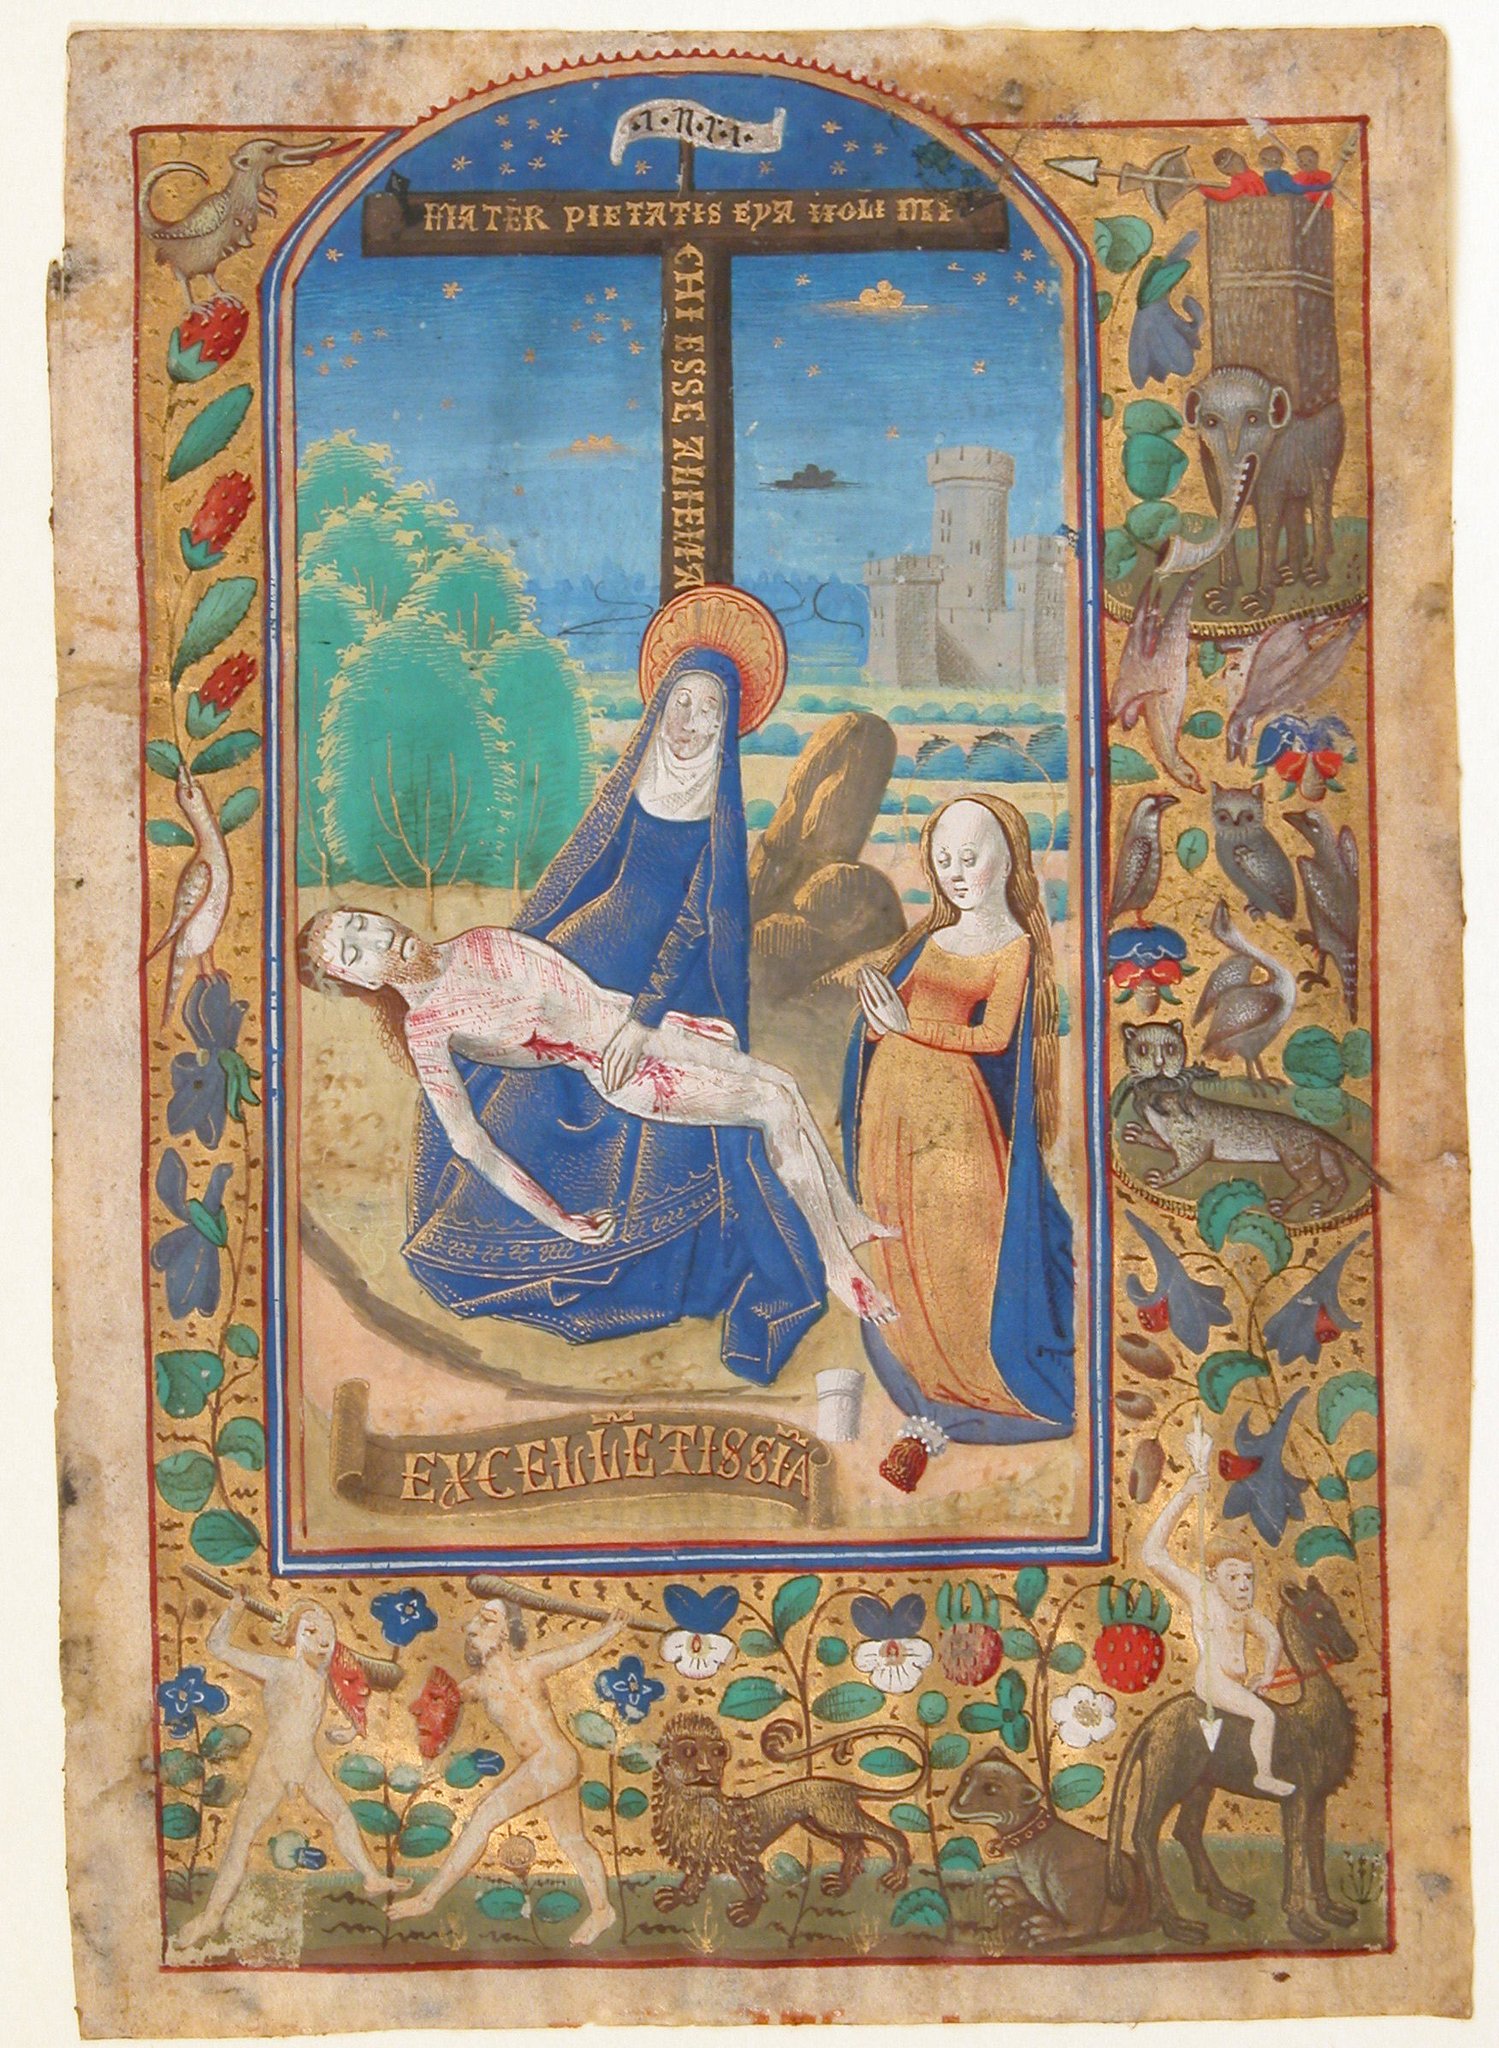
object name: book of hour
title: Manuscript Leaf with the Pièta, from a Book of Hours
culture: french, north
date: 1476-1500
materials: gold, ink, parchment, shell, paint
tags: birds,owls,camels,cats,dogs,elephants,lions,christ,virgin mary,lamentation